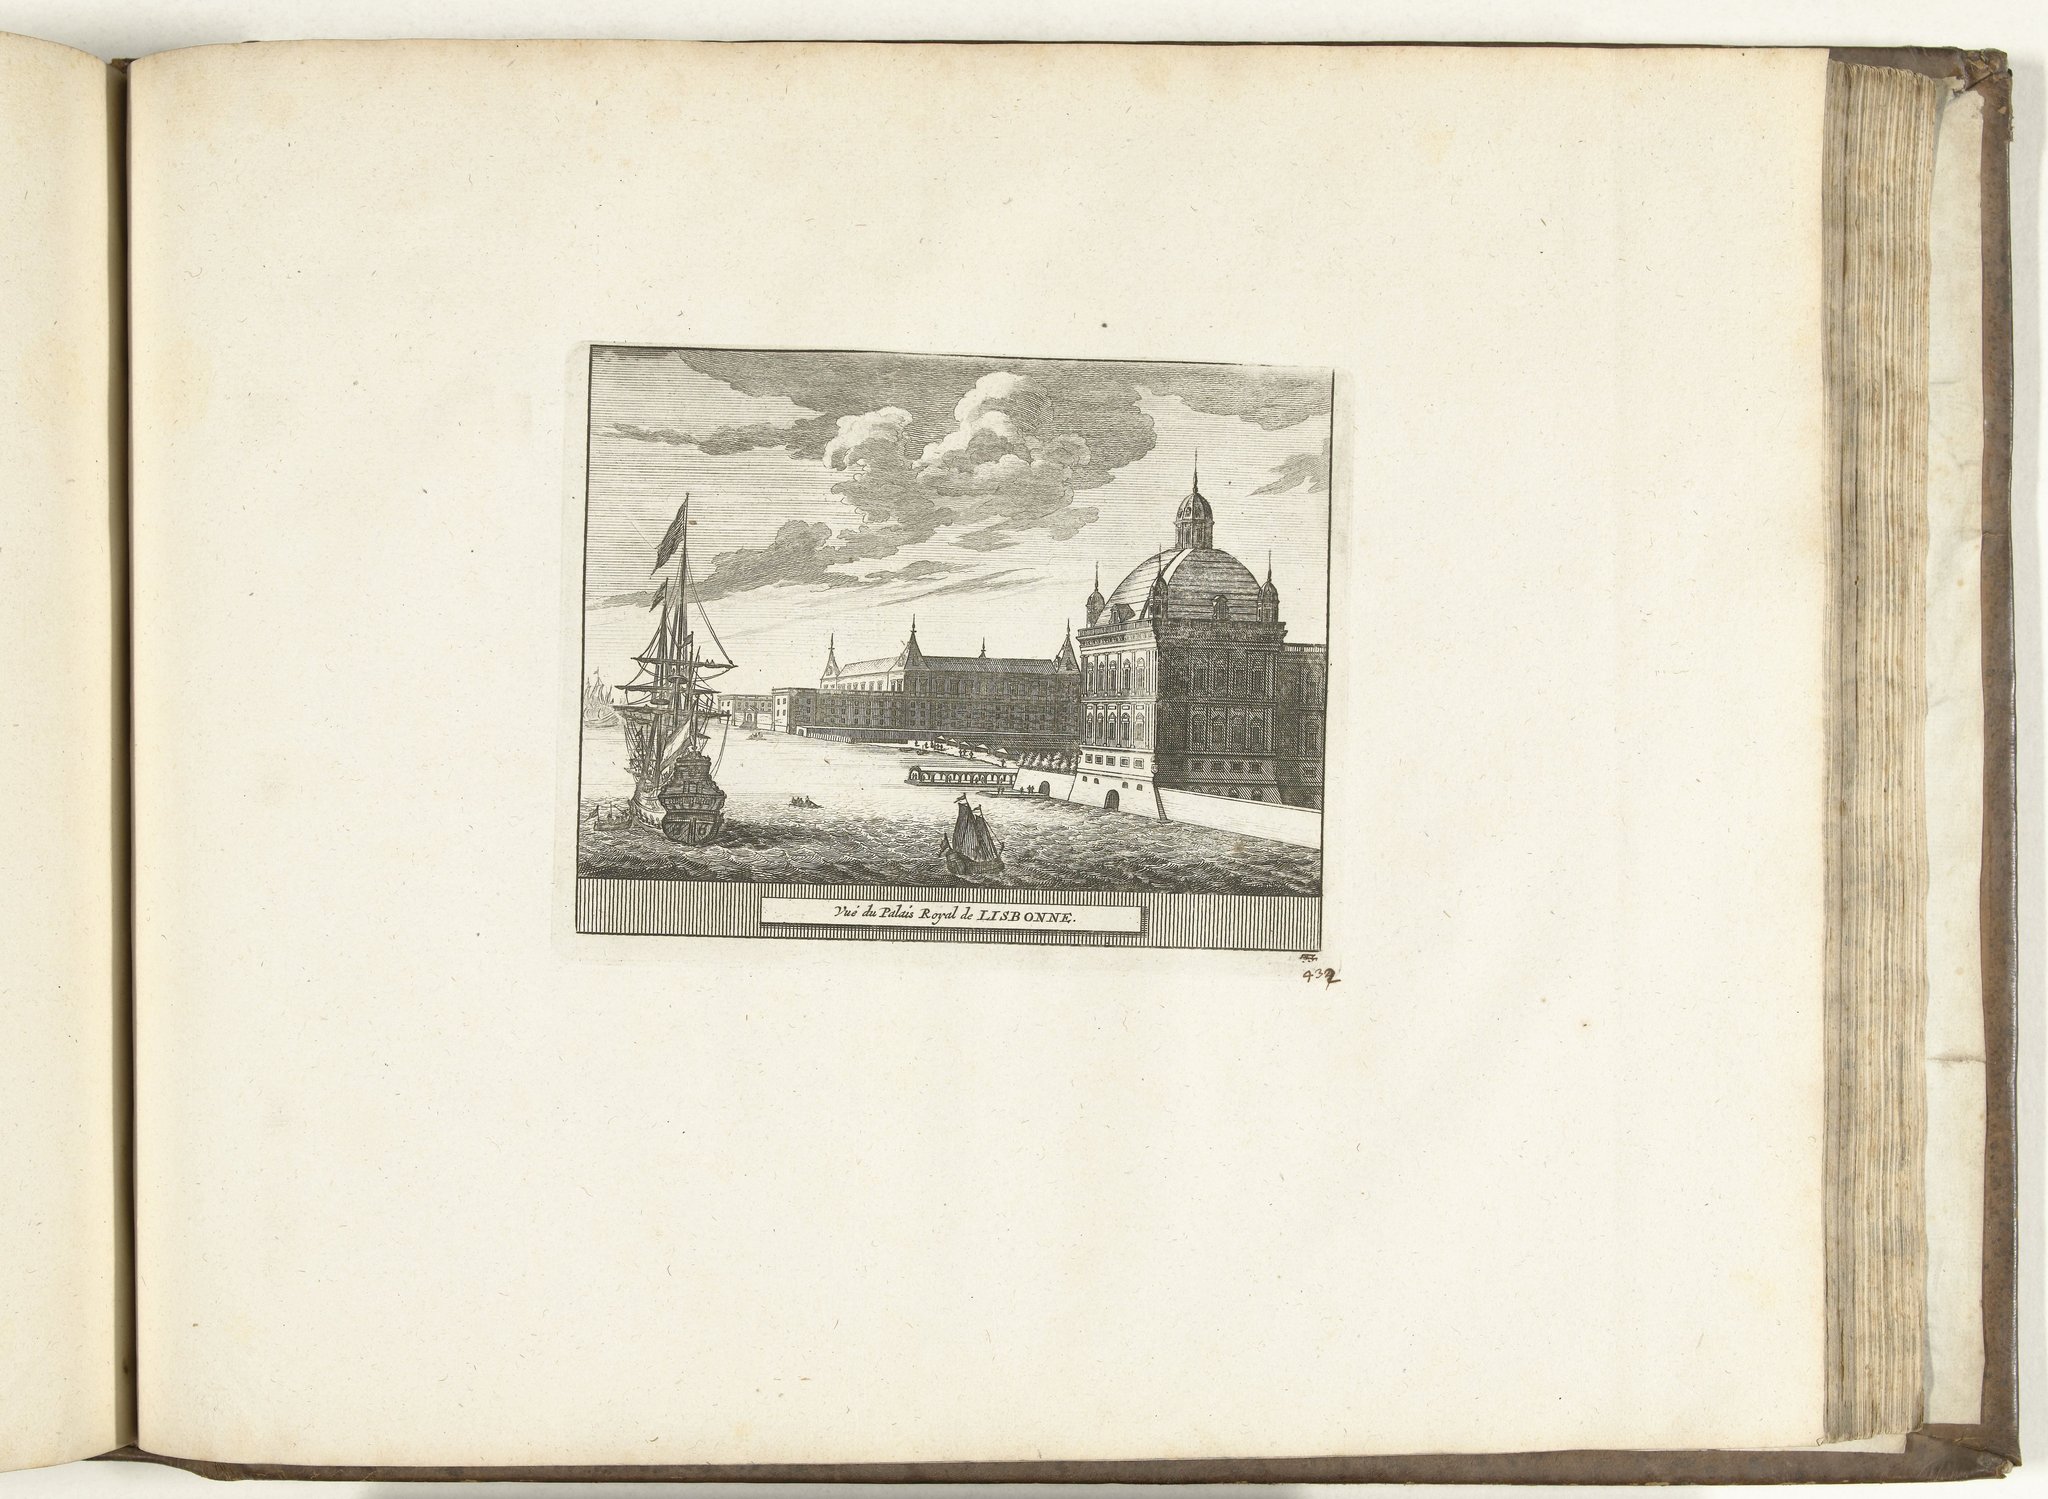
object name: print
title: Het Ribeira Paleis te Lissabon, 1726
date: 1726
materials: paper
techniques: etching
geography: leiden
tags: palace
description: Gezicht op het Paço da Ribeira (Ribeira Koninklijke Paleis) te Lissabon. Plaat nr. 432 in deel XVII van het prentwerk: Les Forces de l'Europe, Asie, Afrique et Amerique ... Comme aussi les Cartes des Côtes de France et d'Espagne uit 1726, dit tweede deel met 271 met de hand genummerde platen van vermaarde sterke steden en vestingen in het kader van de Spaanse Successieoorlog 1701-1713. Voor het merendeel zijn deze platen gekopieerd naar de anonieme Franse platen van vermaarde sterke steden en vestingen: in Les forces de l'Europe en in: Le theatre de la guerre, dans les Pays-Bas, beide oorspronkelijk uitgegeven door Nicolas de Fer te Parijs (1693-1697) in het kader van de Negenjarige Oorlog. Titel in het Frans. Rechtsonder het nummer 143 met de pen doorgekrast.